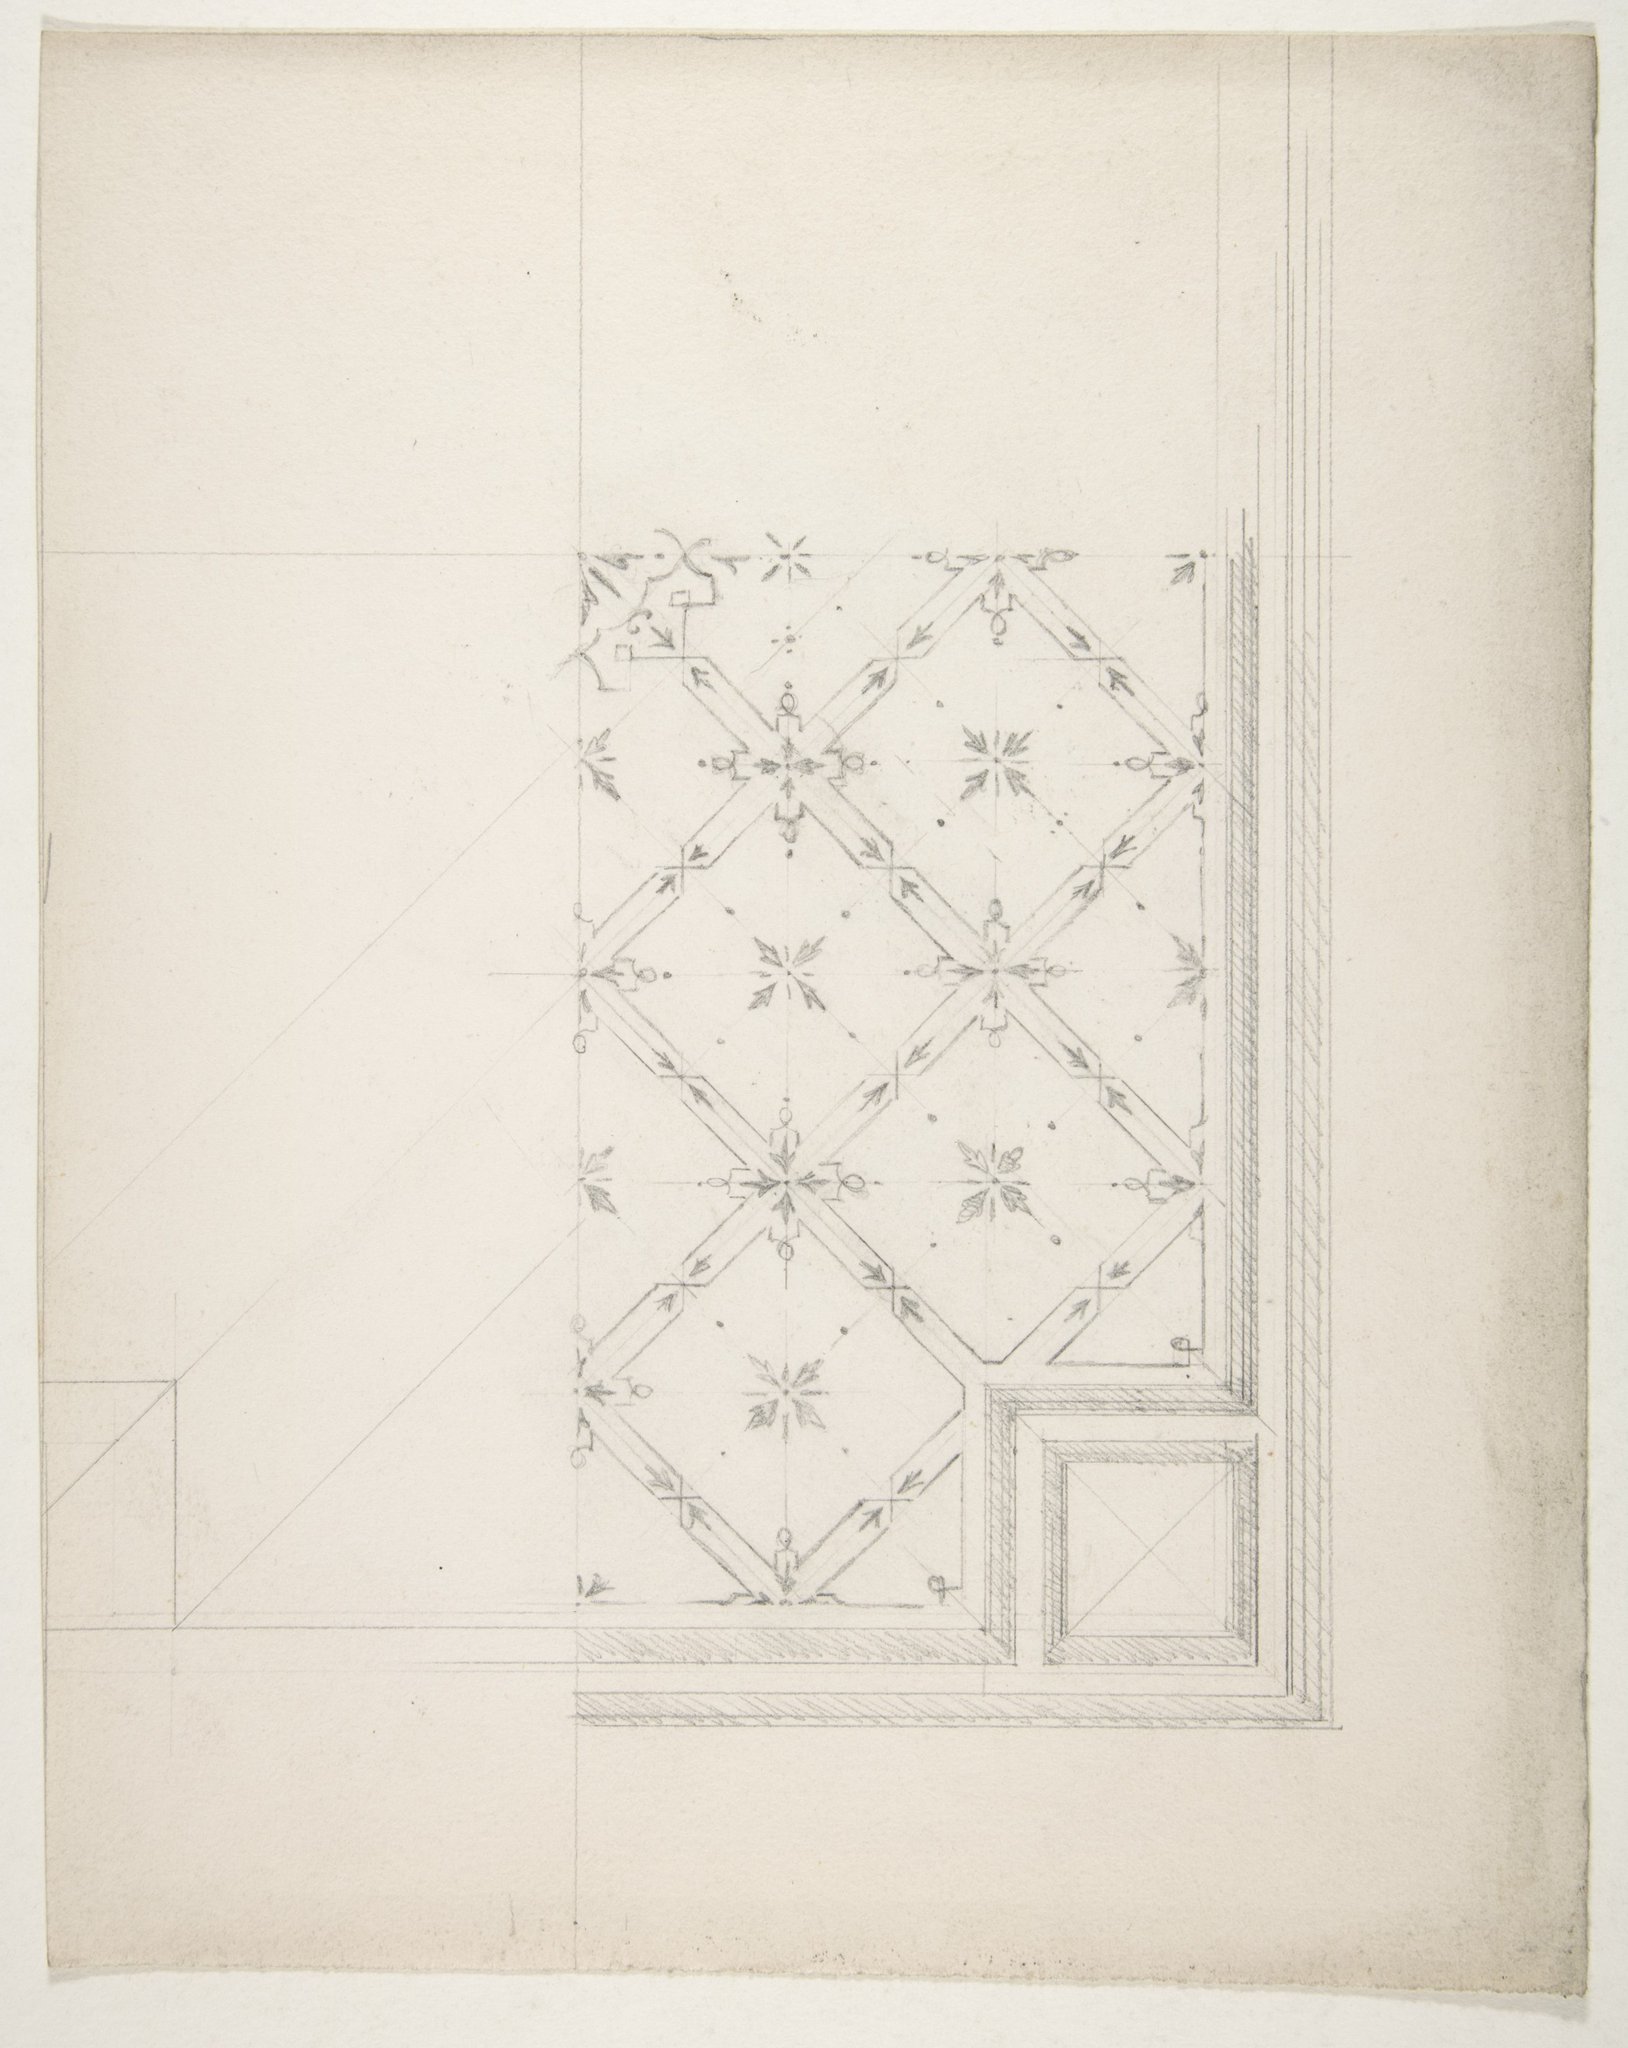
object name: drawing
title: Partial design for the decoration of a ceiling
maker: jules-edmond-charles lachaise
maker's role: artist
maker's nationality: french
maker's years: 1897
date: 1830-1897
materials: graphite, paper